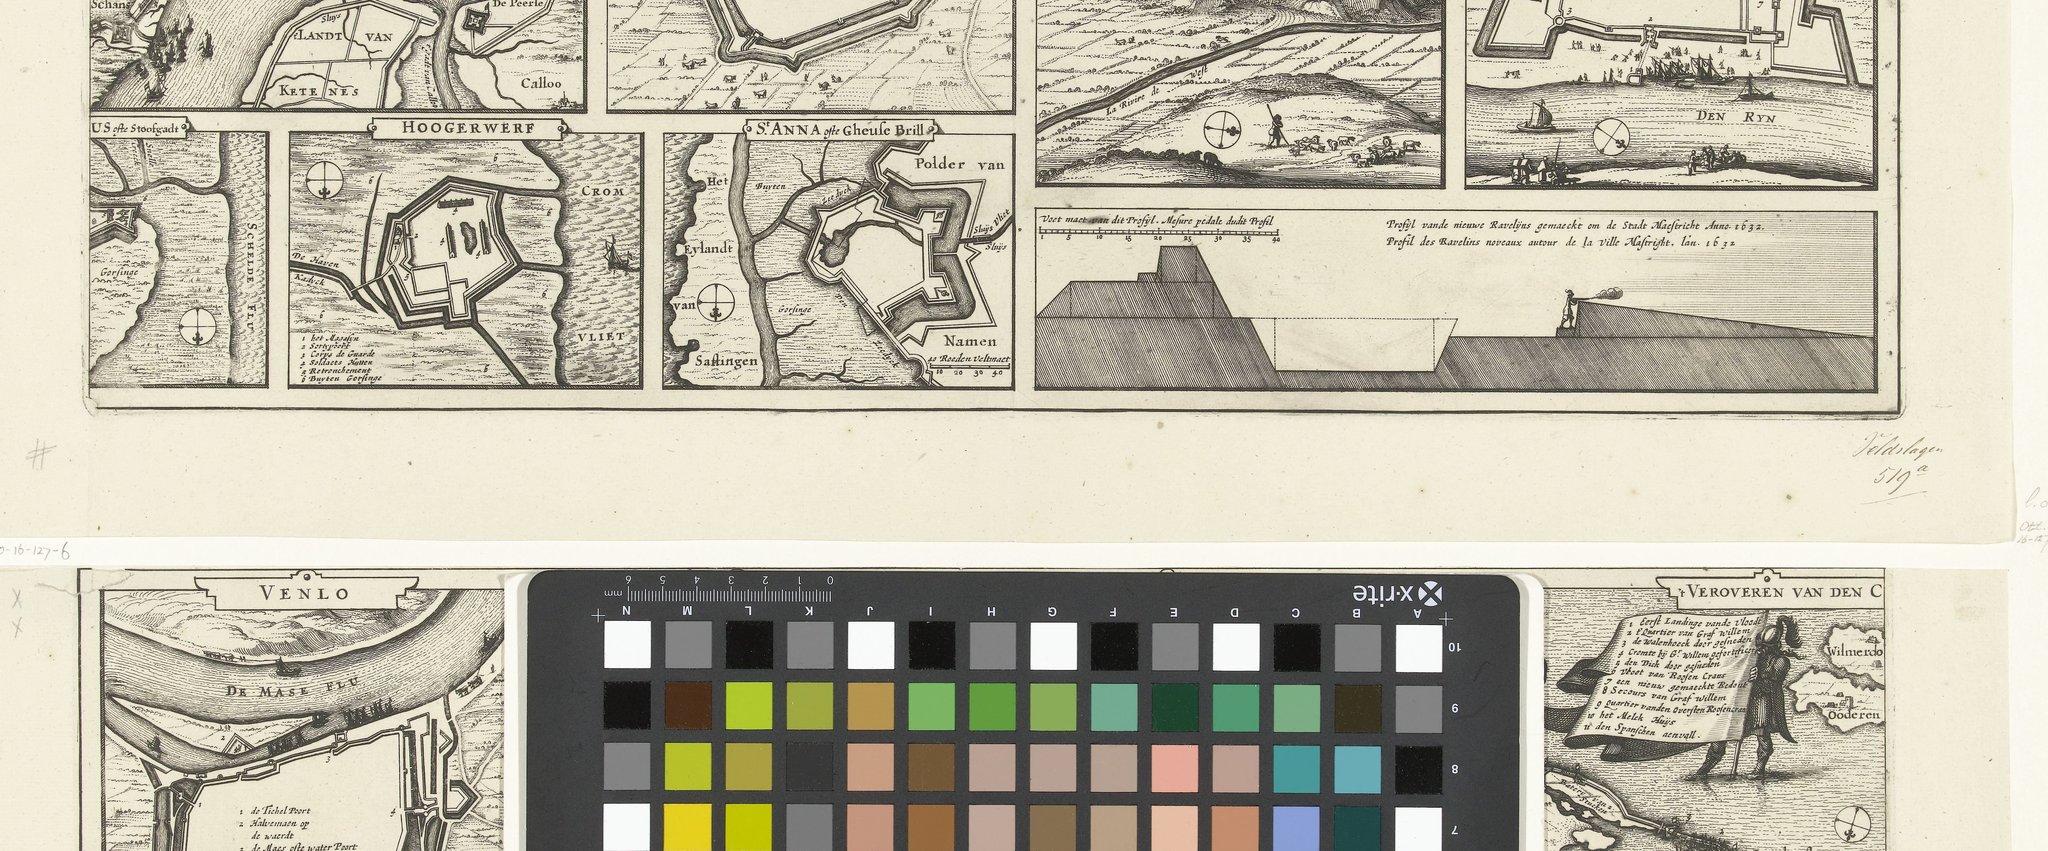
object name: map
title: Beleg van Maastricht, 1632 (plaat 6)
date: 1633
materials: paper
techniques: etching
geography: the hague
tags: delft, frederick henry (prince of orange), fortifications, military engineering, maps of cities, maastricht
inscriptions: inscription: ‘Veldslagen 519a’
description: Kaart van het beleg en de inname van Maastricht door het Staatse leger onder stadhouder Frederik Hendrik, 9 juni tot 21 augustus 1632. Kaart samengesteld uit zes bladen, drie links en drie rechts. Dit is het blad rechtsonder. Blad met de plattegronden van Straelen, Orsoy verschillende forten, de verovering van de Kauwensteinse dijk bij Antwerpen en de doorsnede van een ravelijn of schans.